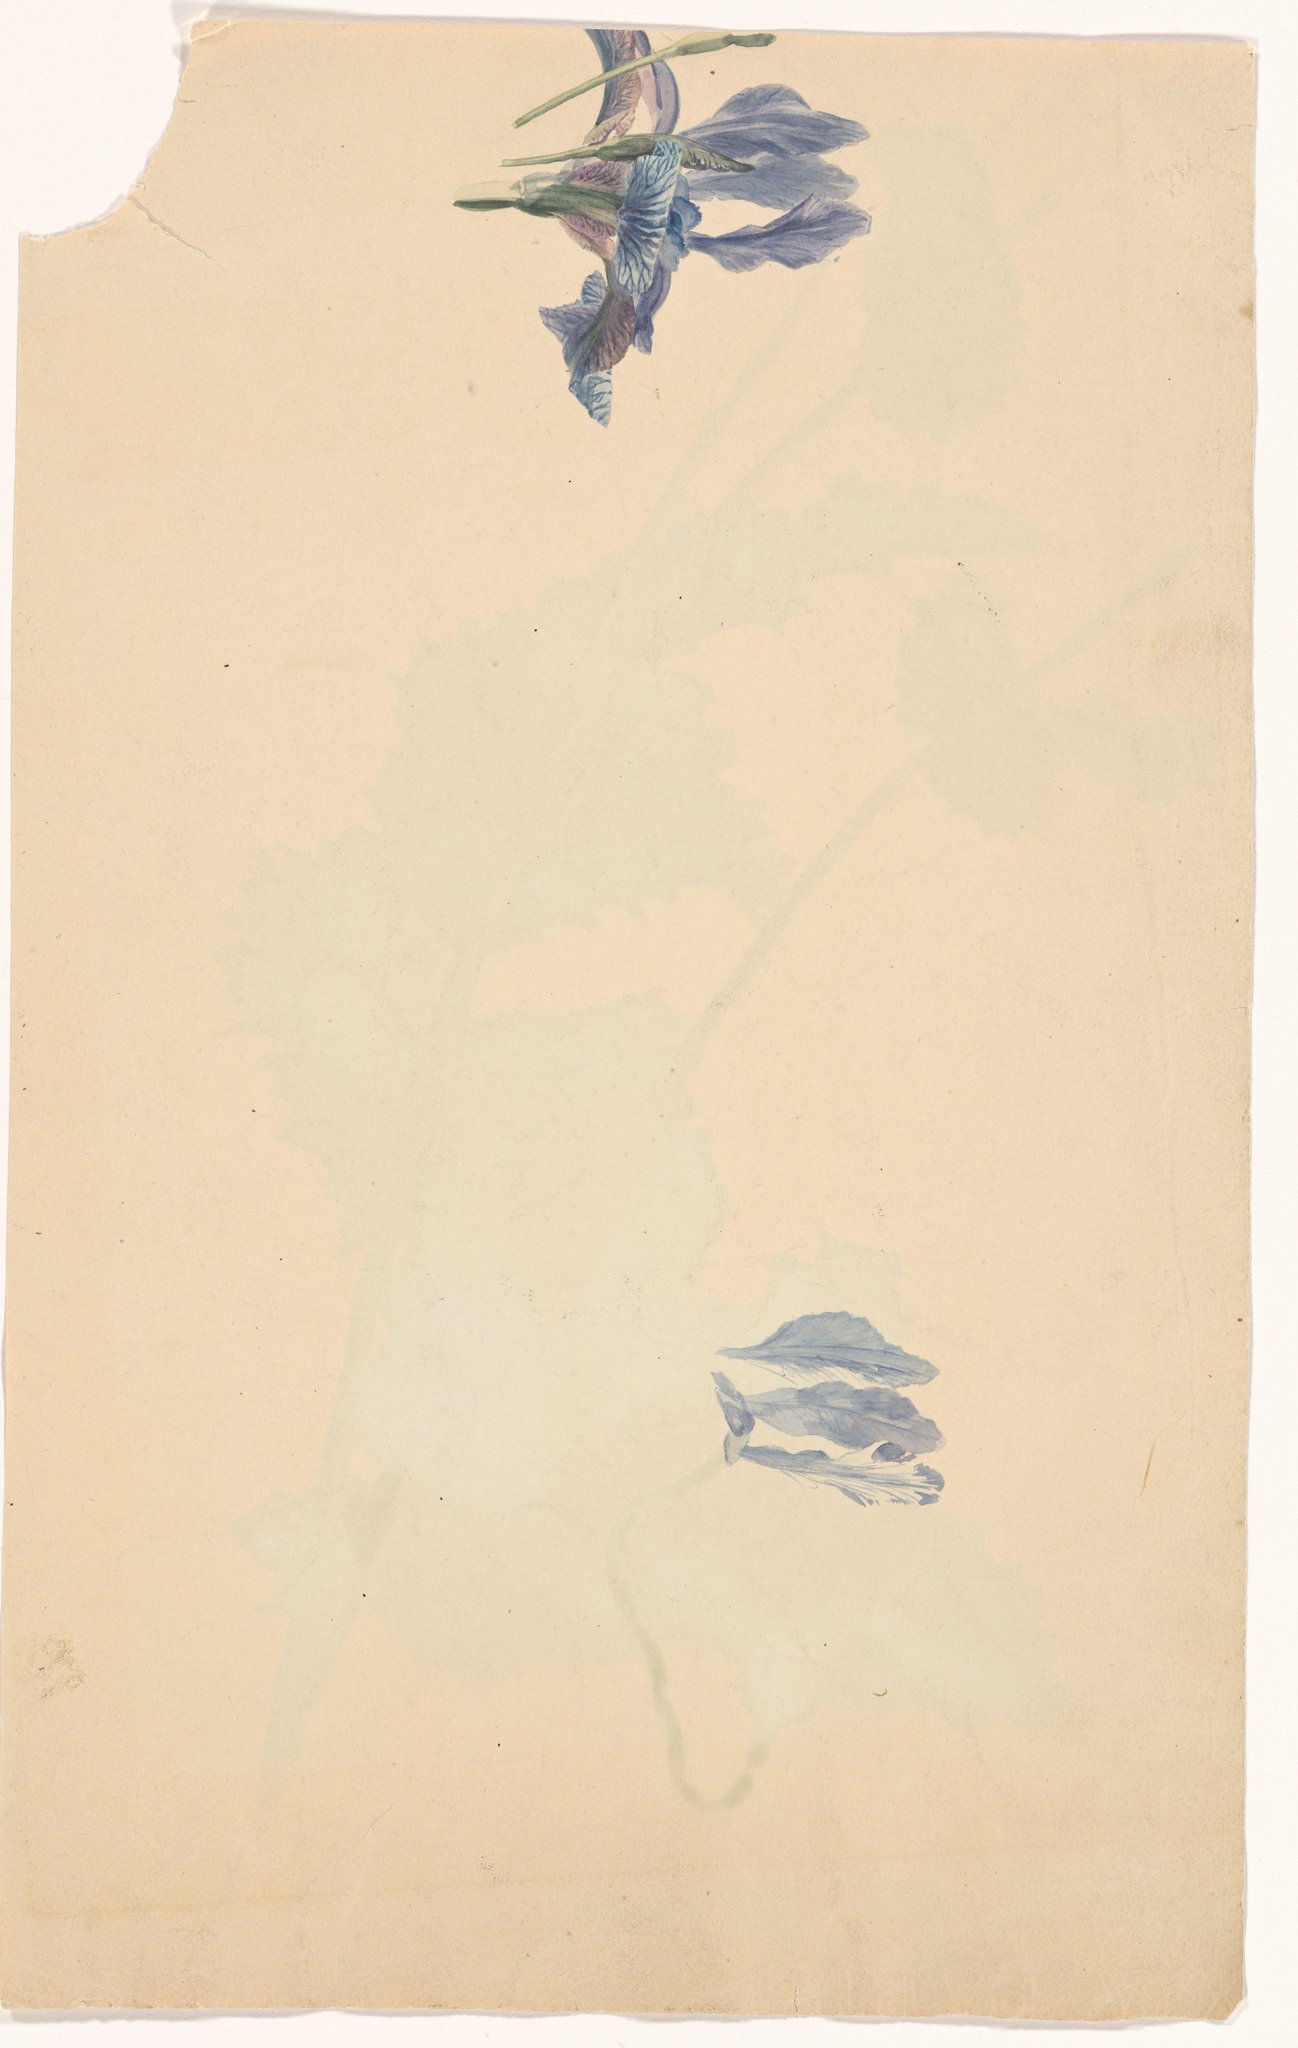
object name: drawing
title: Unknown flower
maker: Anonymous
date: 1815-1830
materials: graphite, paper, watercolor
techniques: drawing